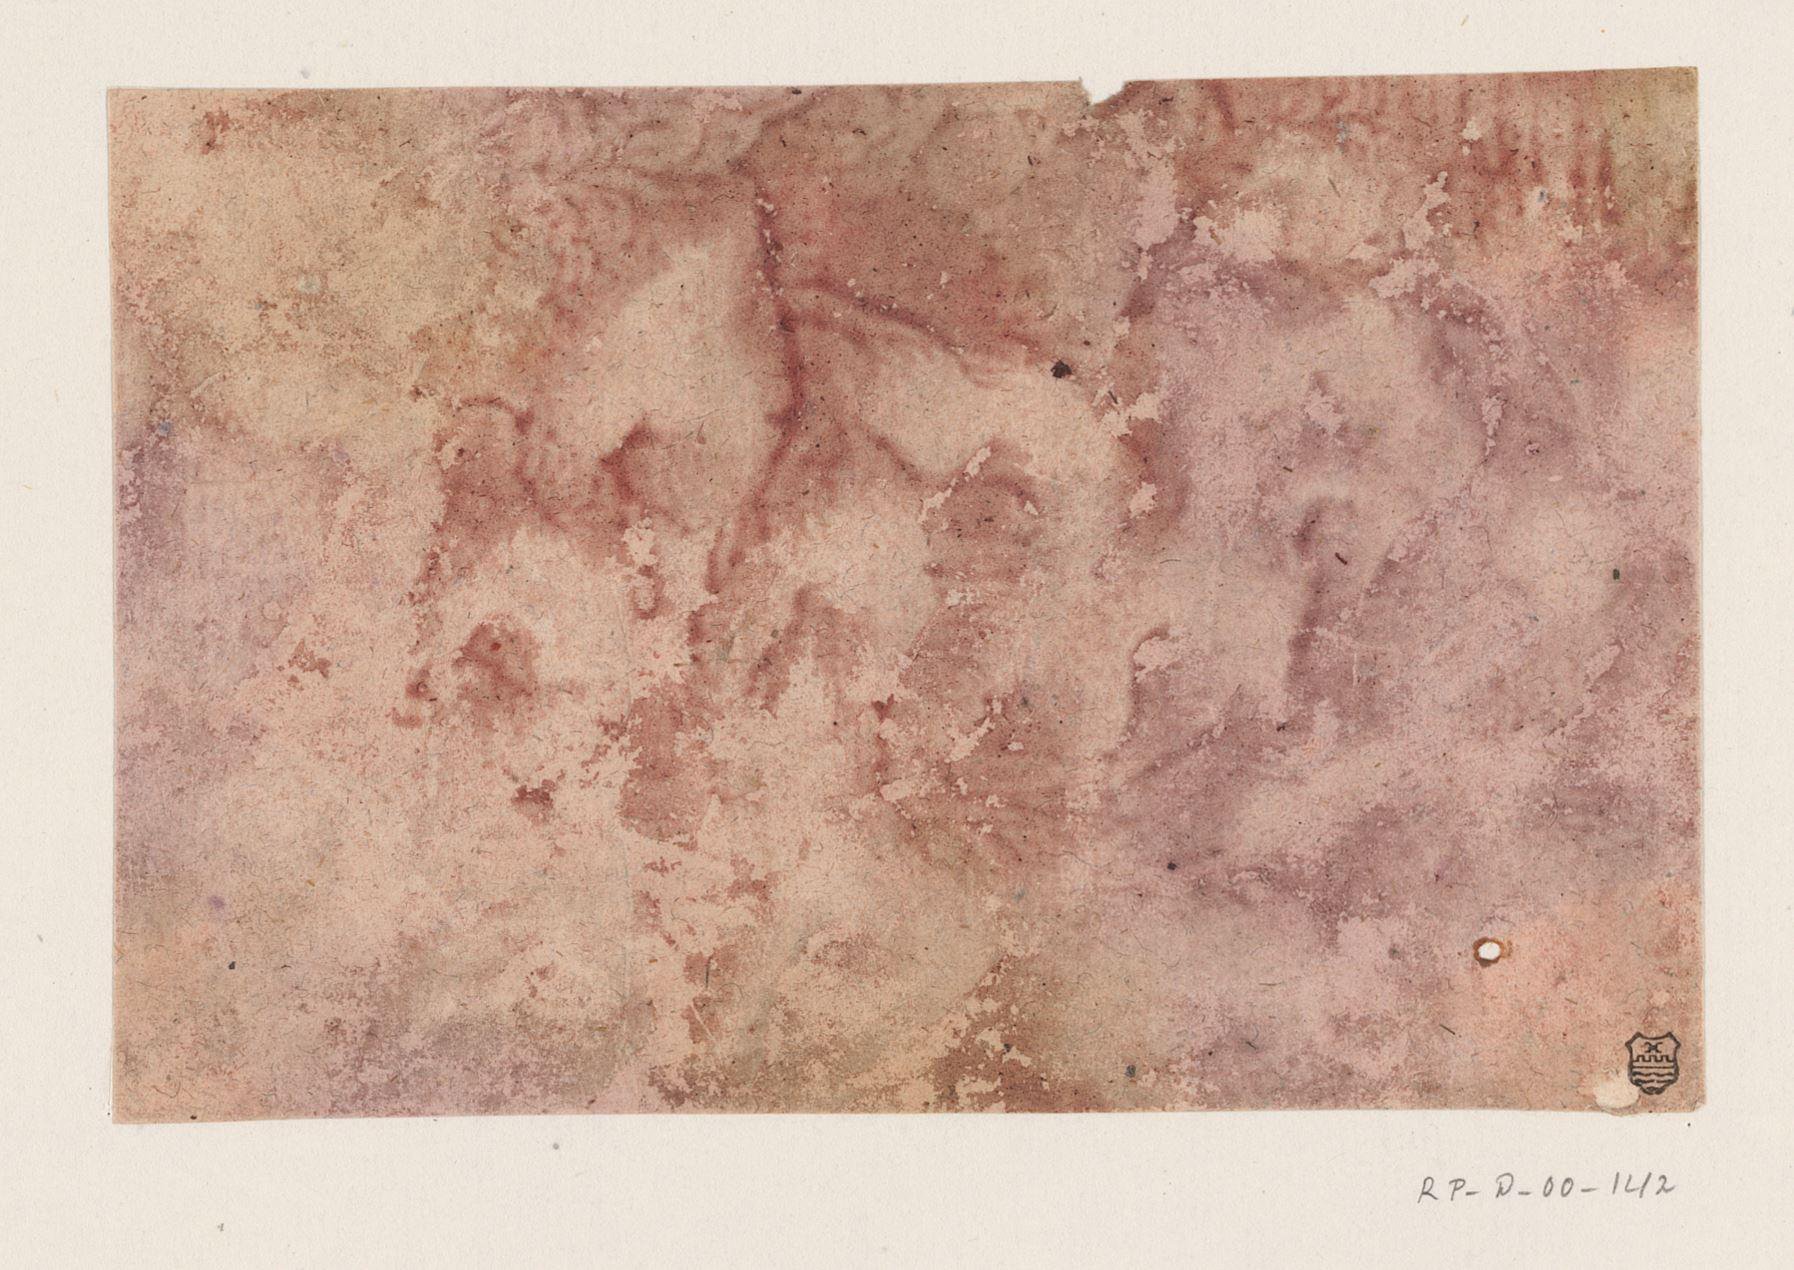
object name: paste paper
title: Geaderd stijfselverfpapier met kleurvlekken in paars, rood en geel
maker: Anonymous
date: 1700-1900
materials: paper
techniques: starch dyeing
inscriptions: collector's mark: Lugt 2760